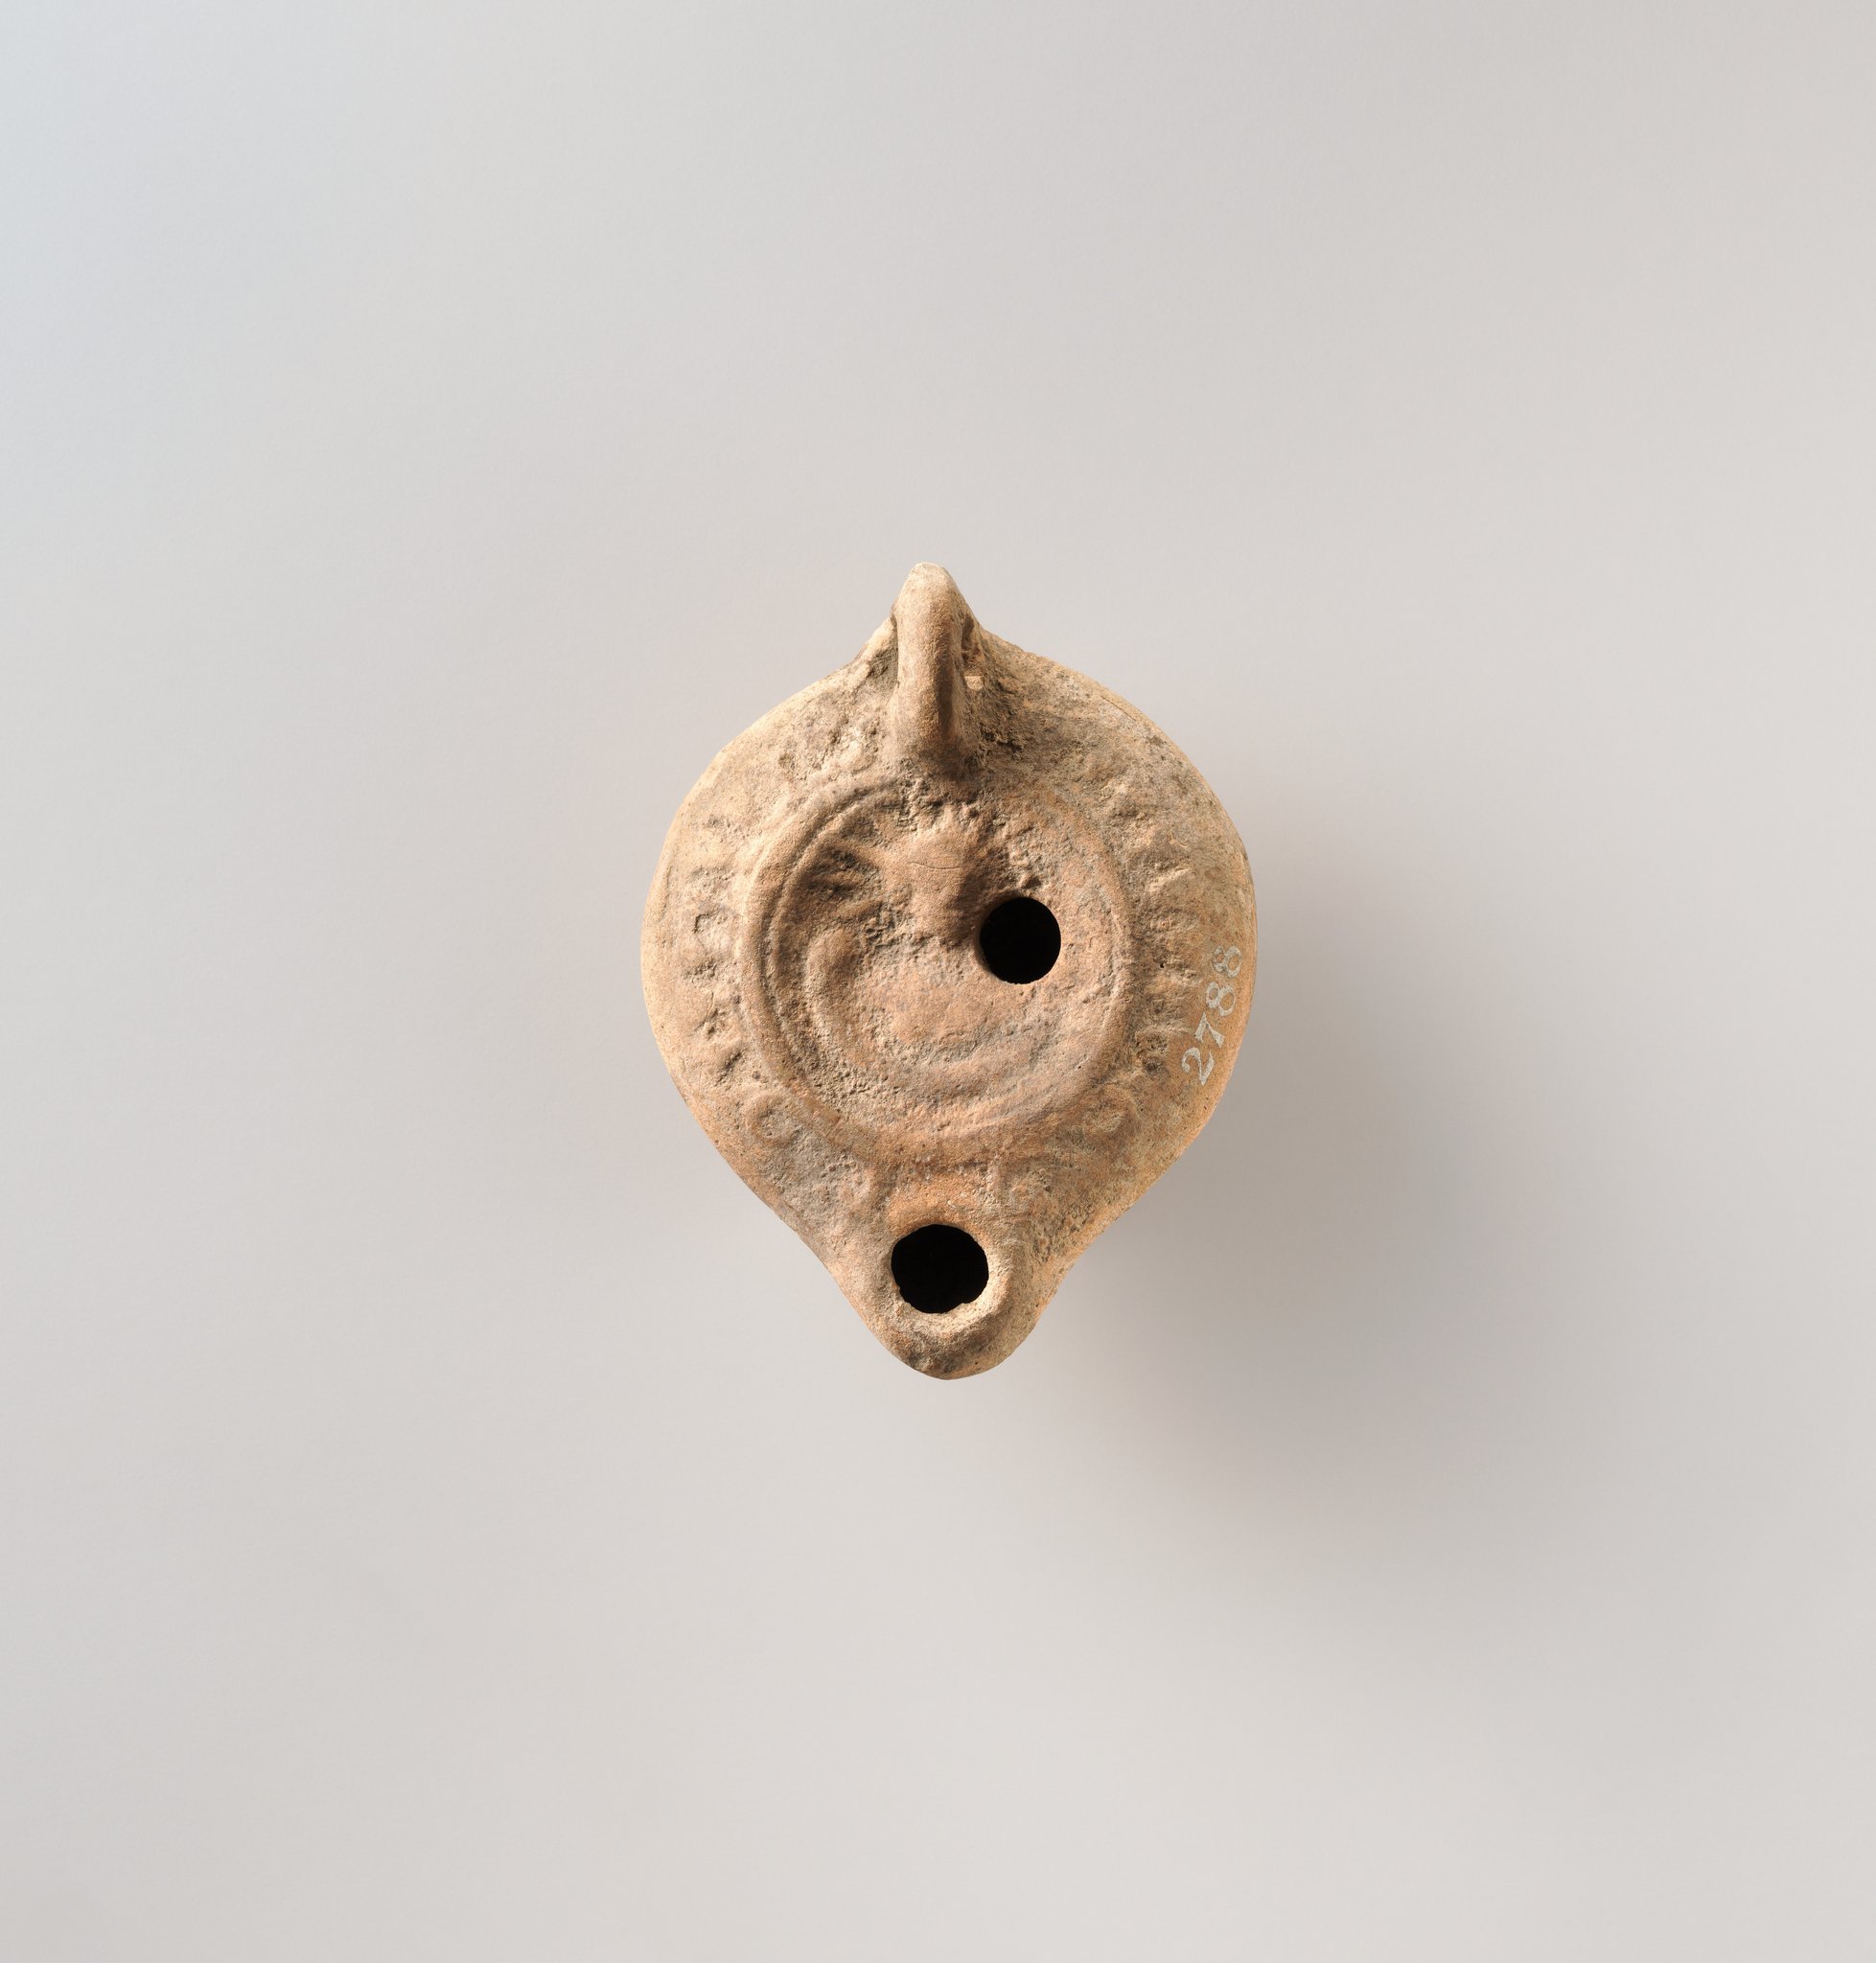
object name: lamp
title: Terracotta oil lamp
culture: roman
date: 101-200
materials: terracotta